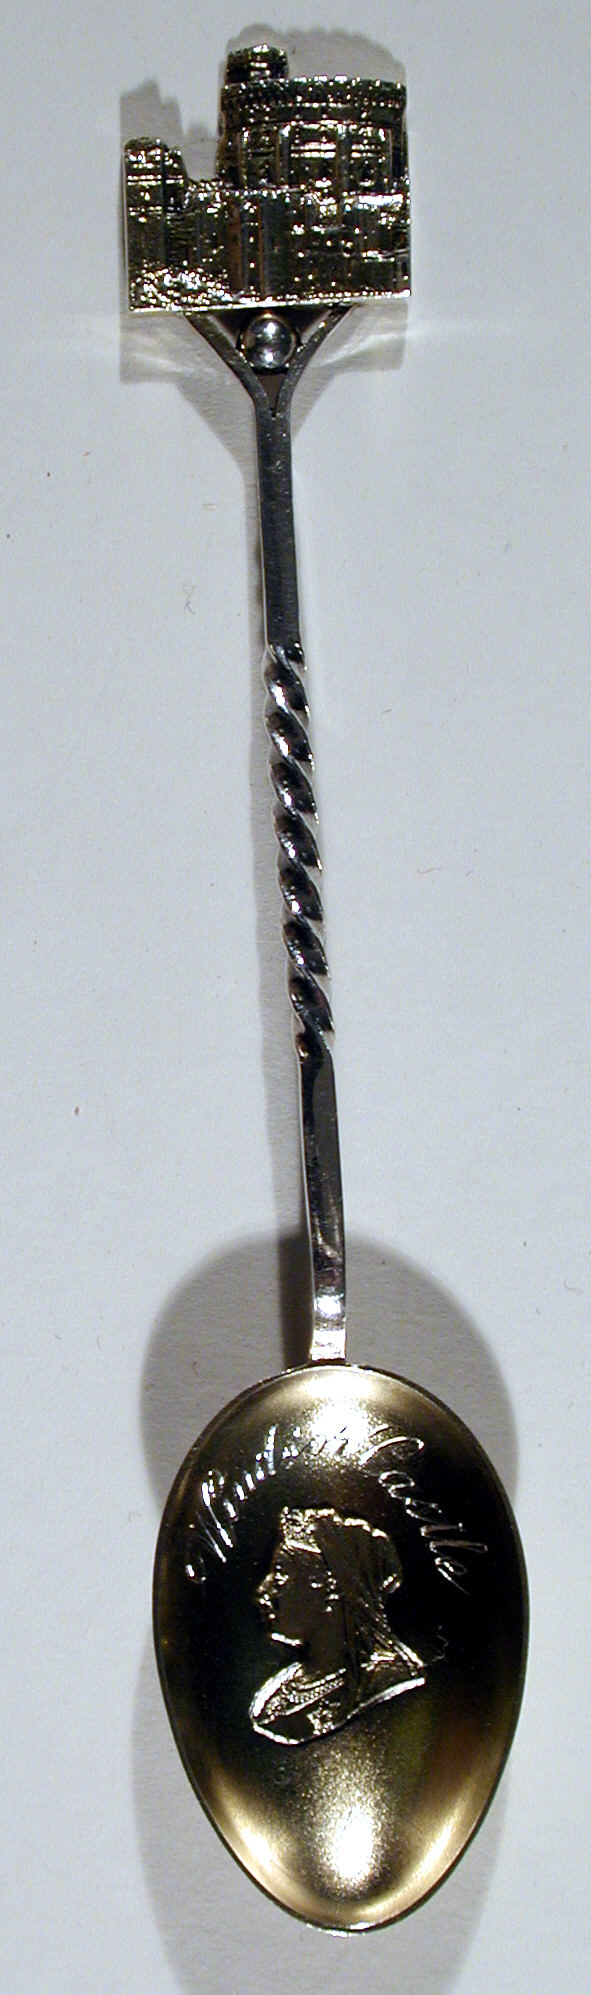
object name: souvenir spoon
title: Souvenir spoon with portrait of Queen Victoria and finial in form of Windsor Castle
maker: saunders & shepherd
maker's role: maker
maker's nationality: british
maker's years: 1869-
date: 1897-1898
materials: gilt, silver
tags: castles,profiles